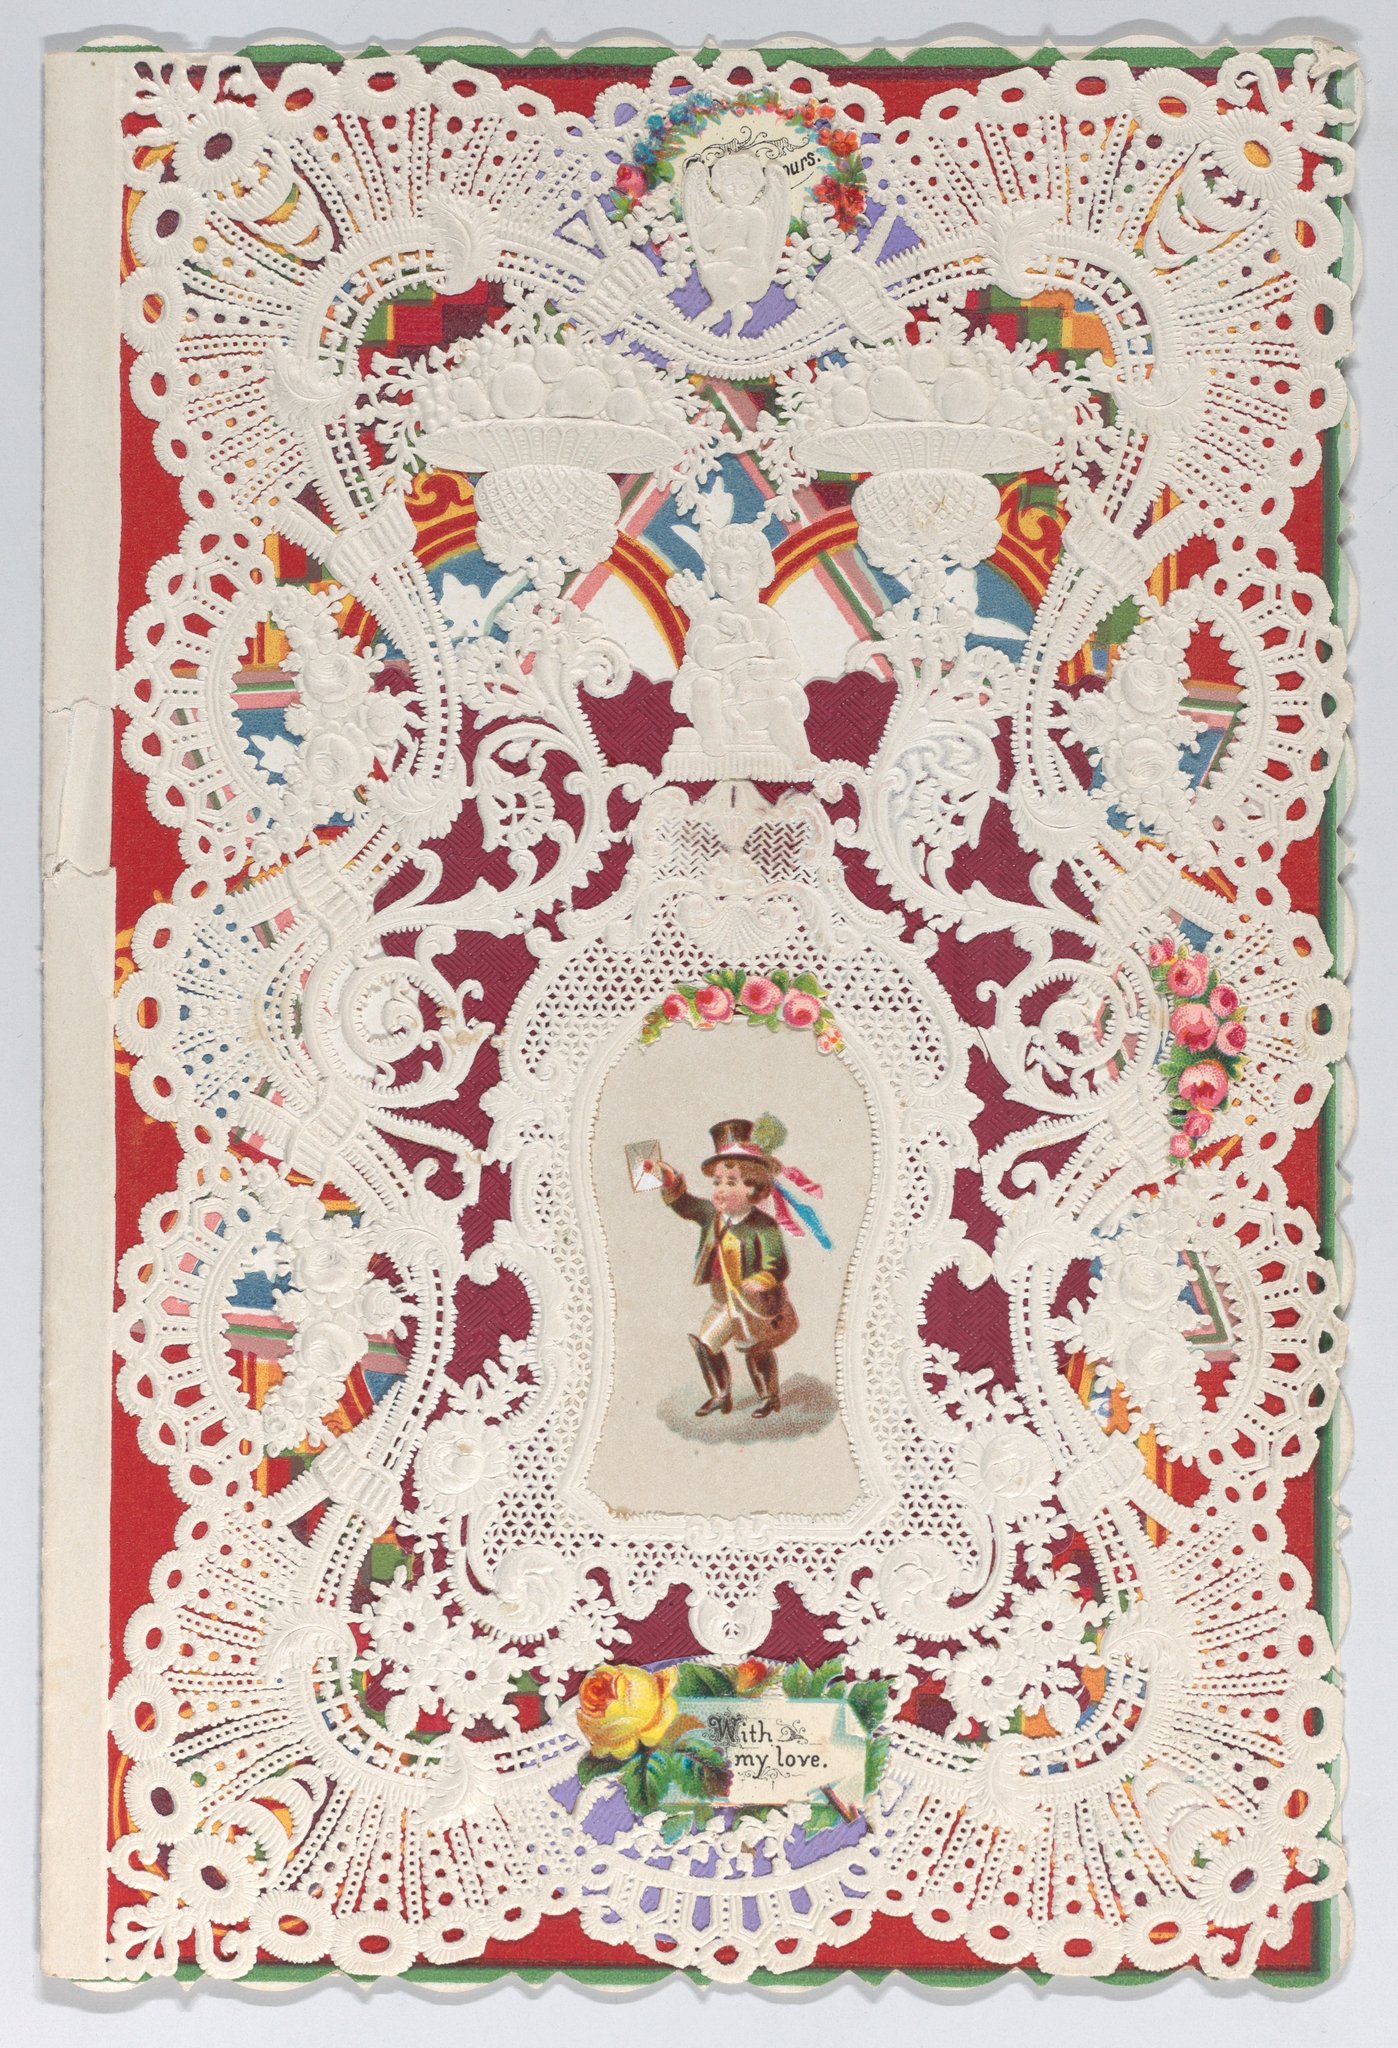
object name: valentine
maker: Anonymous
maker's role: artist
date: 1879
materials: lace, paper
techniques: chromolithography, embossing, open work